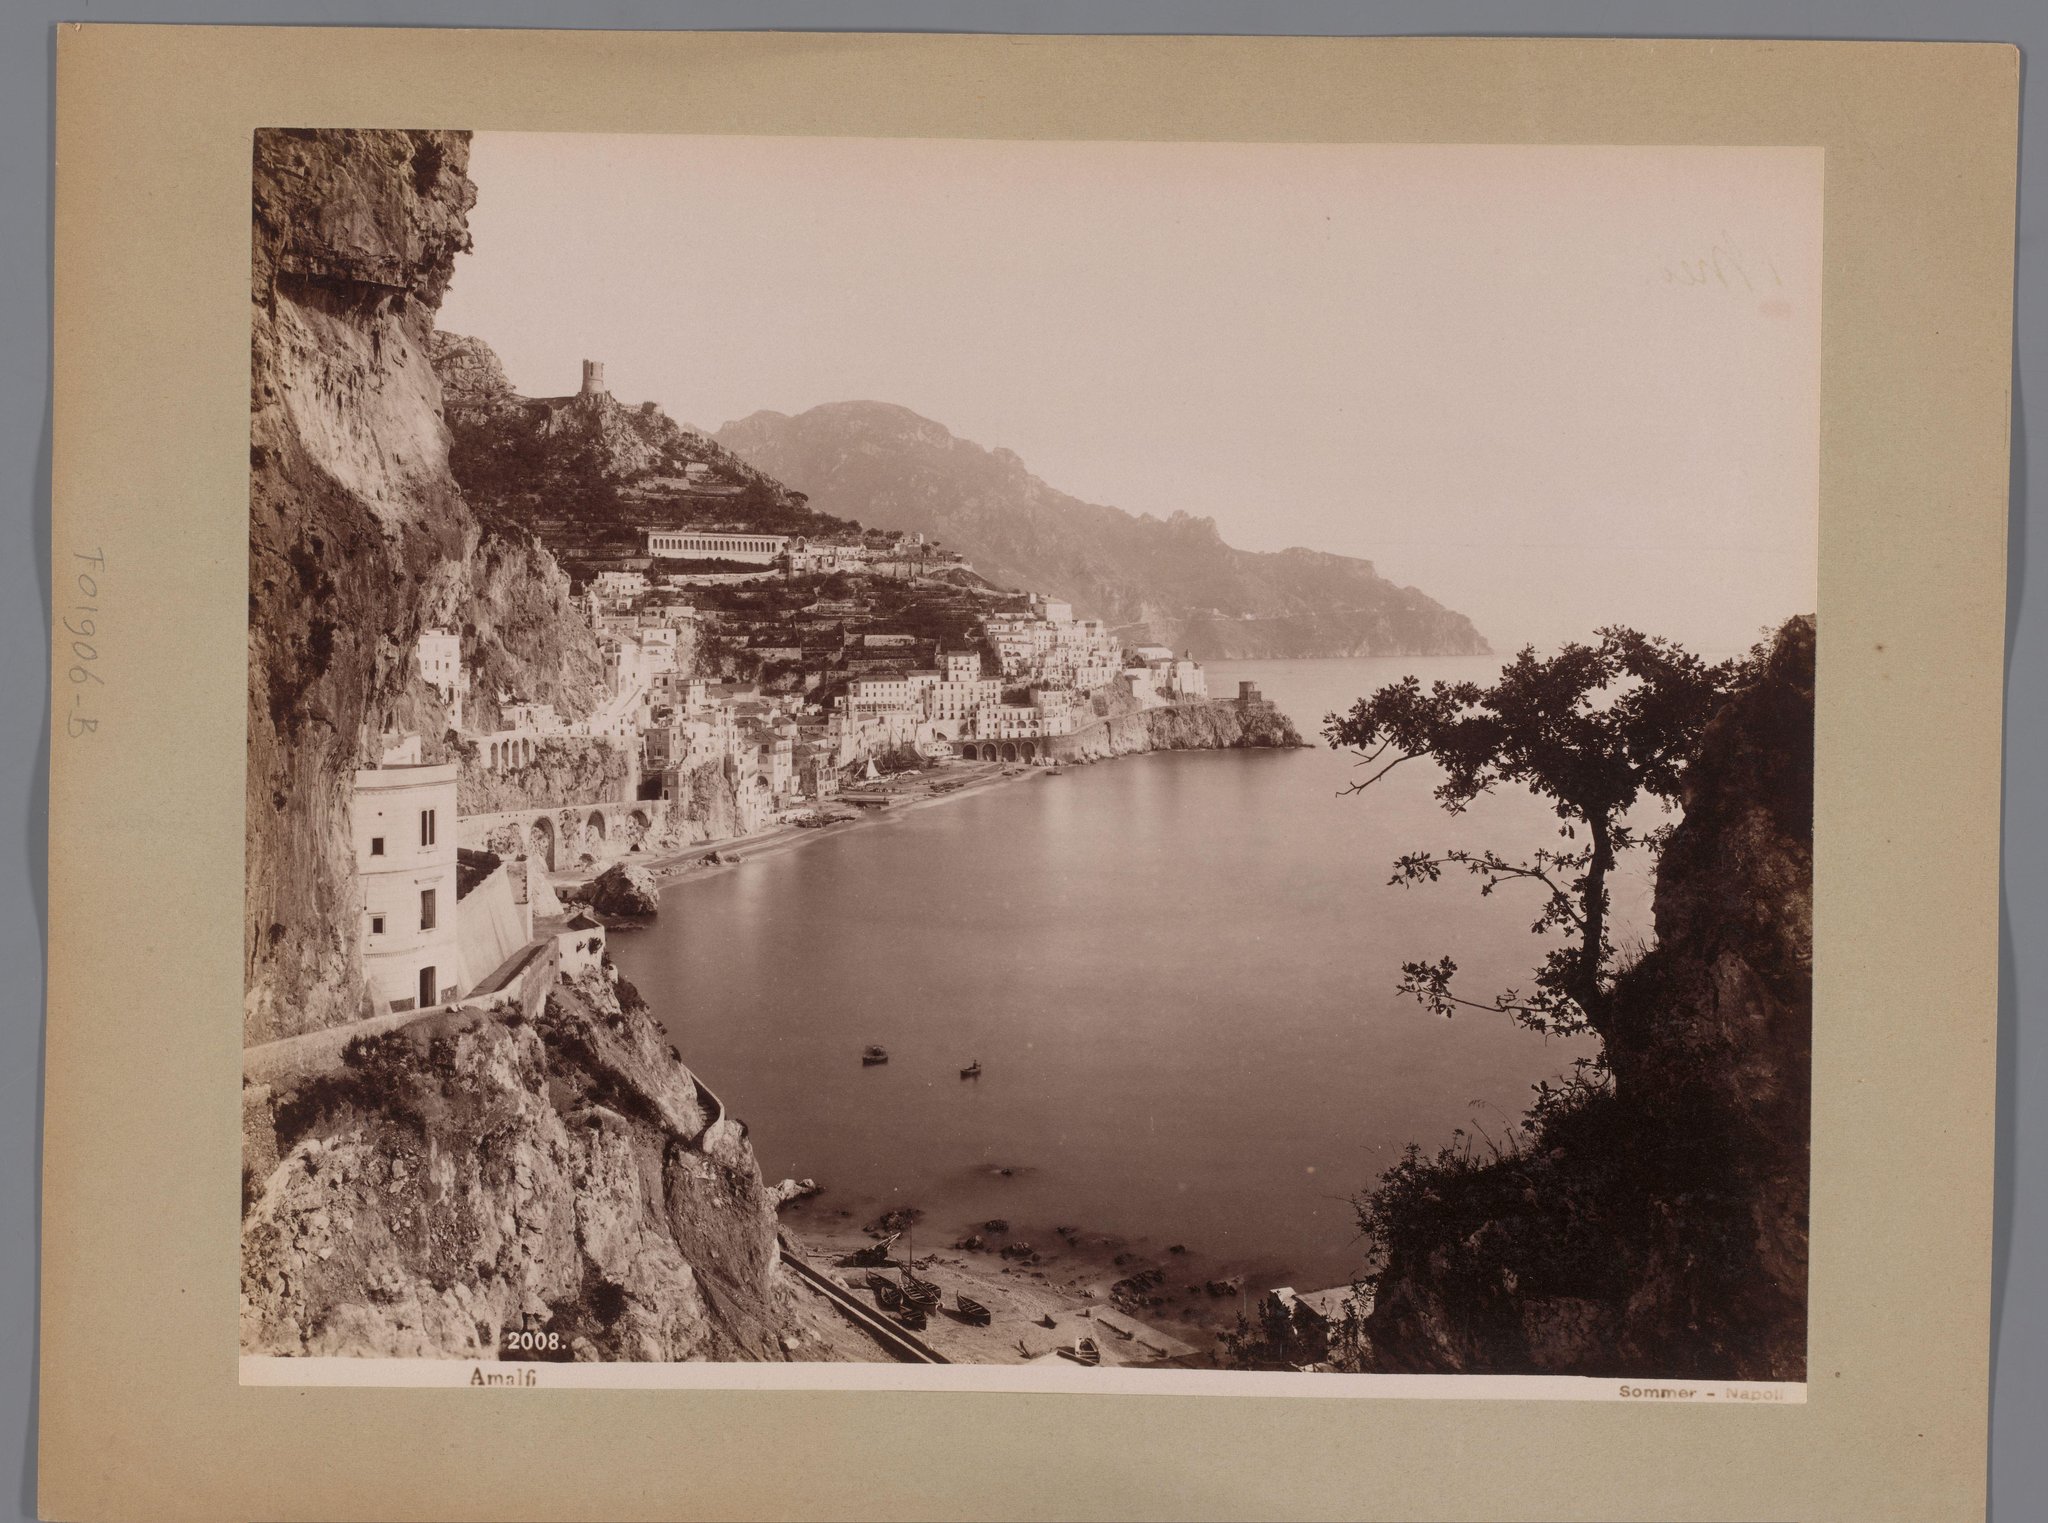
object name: photograph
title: Amalfi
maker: giorgio sommer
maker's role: fotograaf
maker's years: 1834-1914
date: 1899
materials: cardboard, paper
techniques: albumen print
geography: amalfi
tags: gulf, bay, rocky coast, prospect of city, town panorama, silhouette of city, amalfi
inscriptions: number: ‘2008.’